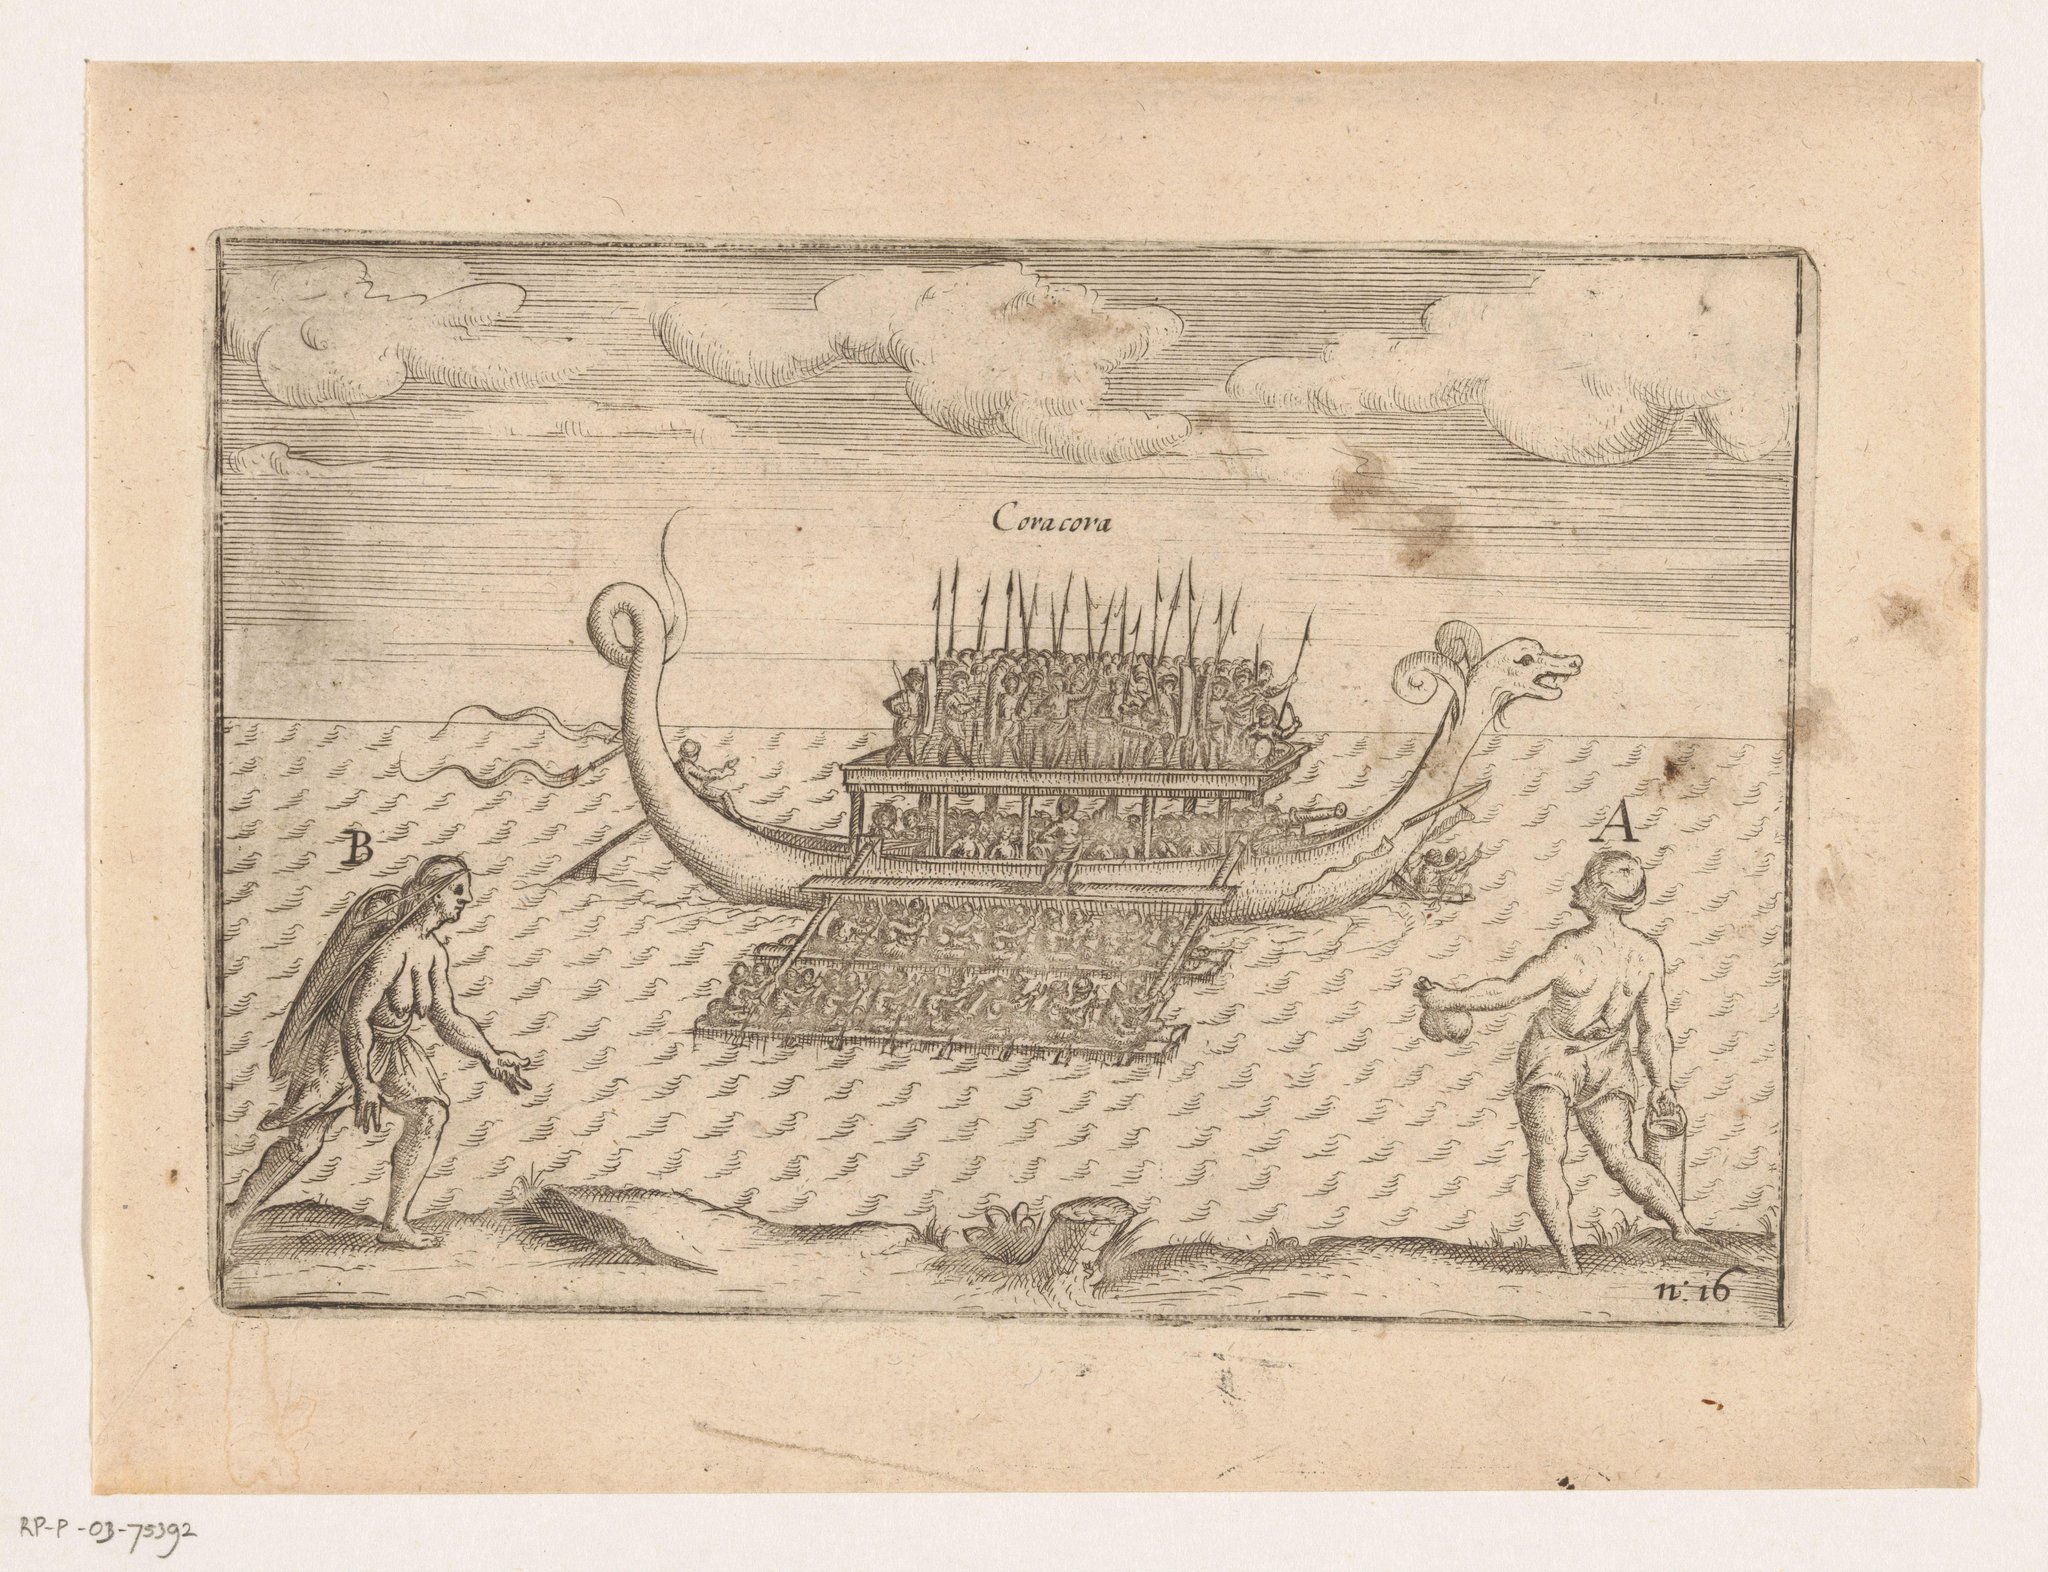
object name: print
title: Coracora van de Banda-eilanden, 1599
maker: Anonymous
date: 1600-1601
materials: paper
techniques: engraving, etching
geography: northern netherlands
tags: mayor, amsterdam, landscapes in tropical and sub-tropical regions, warfare; military affairs (+ oared ships, e.g.: galley), exploration, expedition, voyage of discovery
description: Gebruikt als illustratie eerst in: Journael ofte Dagh-register, inhoudende een waerachtigh verhael ... vande reyse, ghedaen door de acht schepen van Amsterdamme, onde 'tbeleydt van Iacob Cornelisz. Neck. als Admirael, ende VVybrandt van VVarvvijck, als Vice-admirael, van Amsterdam gheseylt inden jare 1598, Cornelis Claes, Amsterdam [1600], plaat No. 9. In deze staat gebruikt in: Oost-Indische ende West-Indische voyagien, Michiel Colijn, Amsterdam 1619 en later in: Waerachtigh verhael van de Schipvaerd op Oost-Indien ghedaen by de acht Schepen in den jare 1598 van Amsterdam uyt-ghezeylt, onder 't beleyd van den Admirael Jacob Cornelissoon van Neck, ende Vice-Admirael Wybrand van Warwijck. Opgenomen in: I. Commelin, Begin ende voortgangh, van de Vereenighde Nederlantsche Geoctroyeerde Oost-Indische Compagnie, J. Janssonius, Amsterdam 1646. Genummerd: 16.